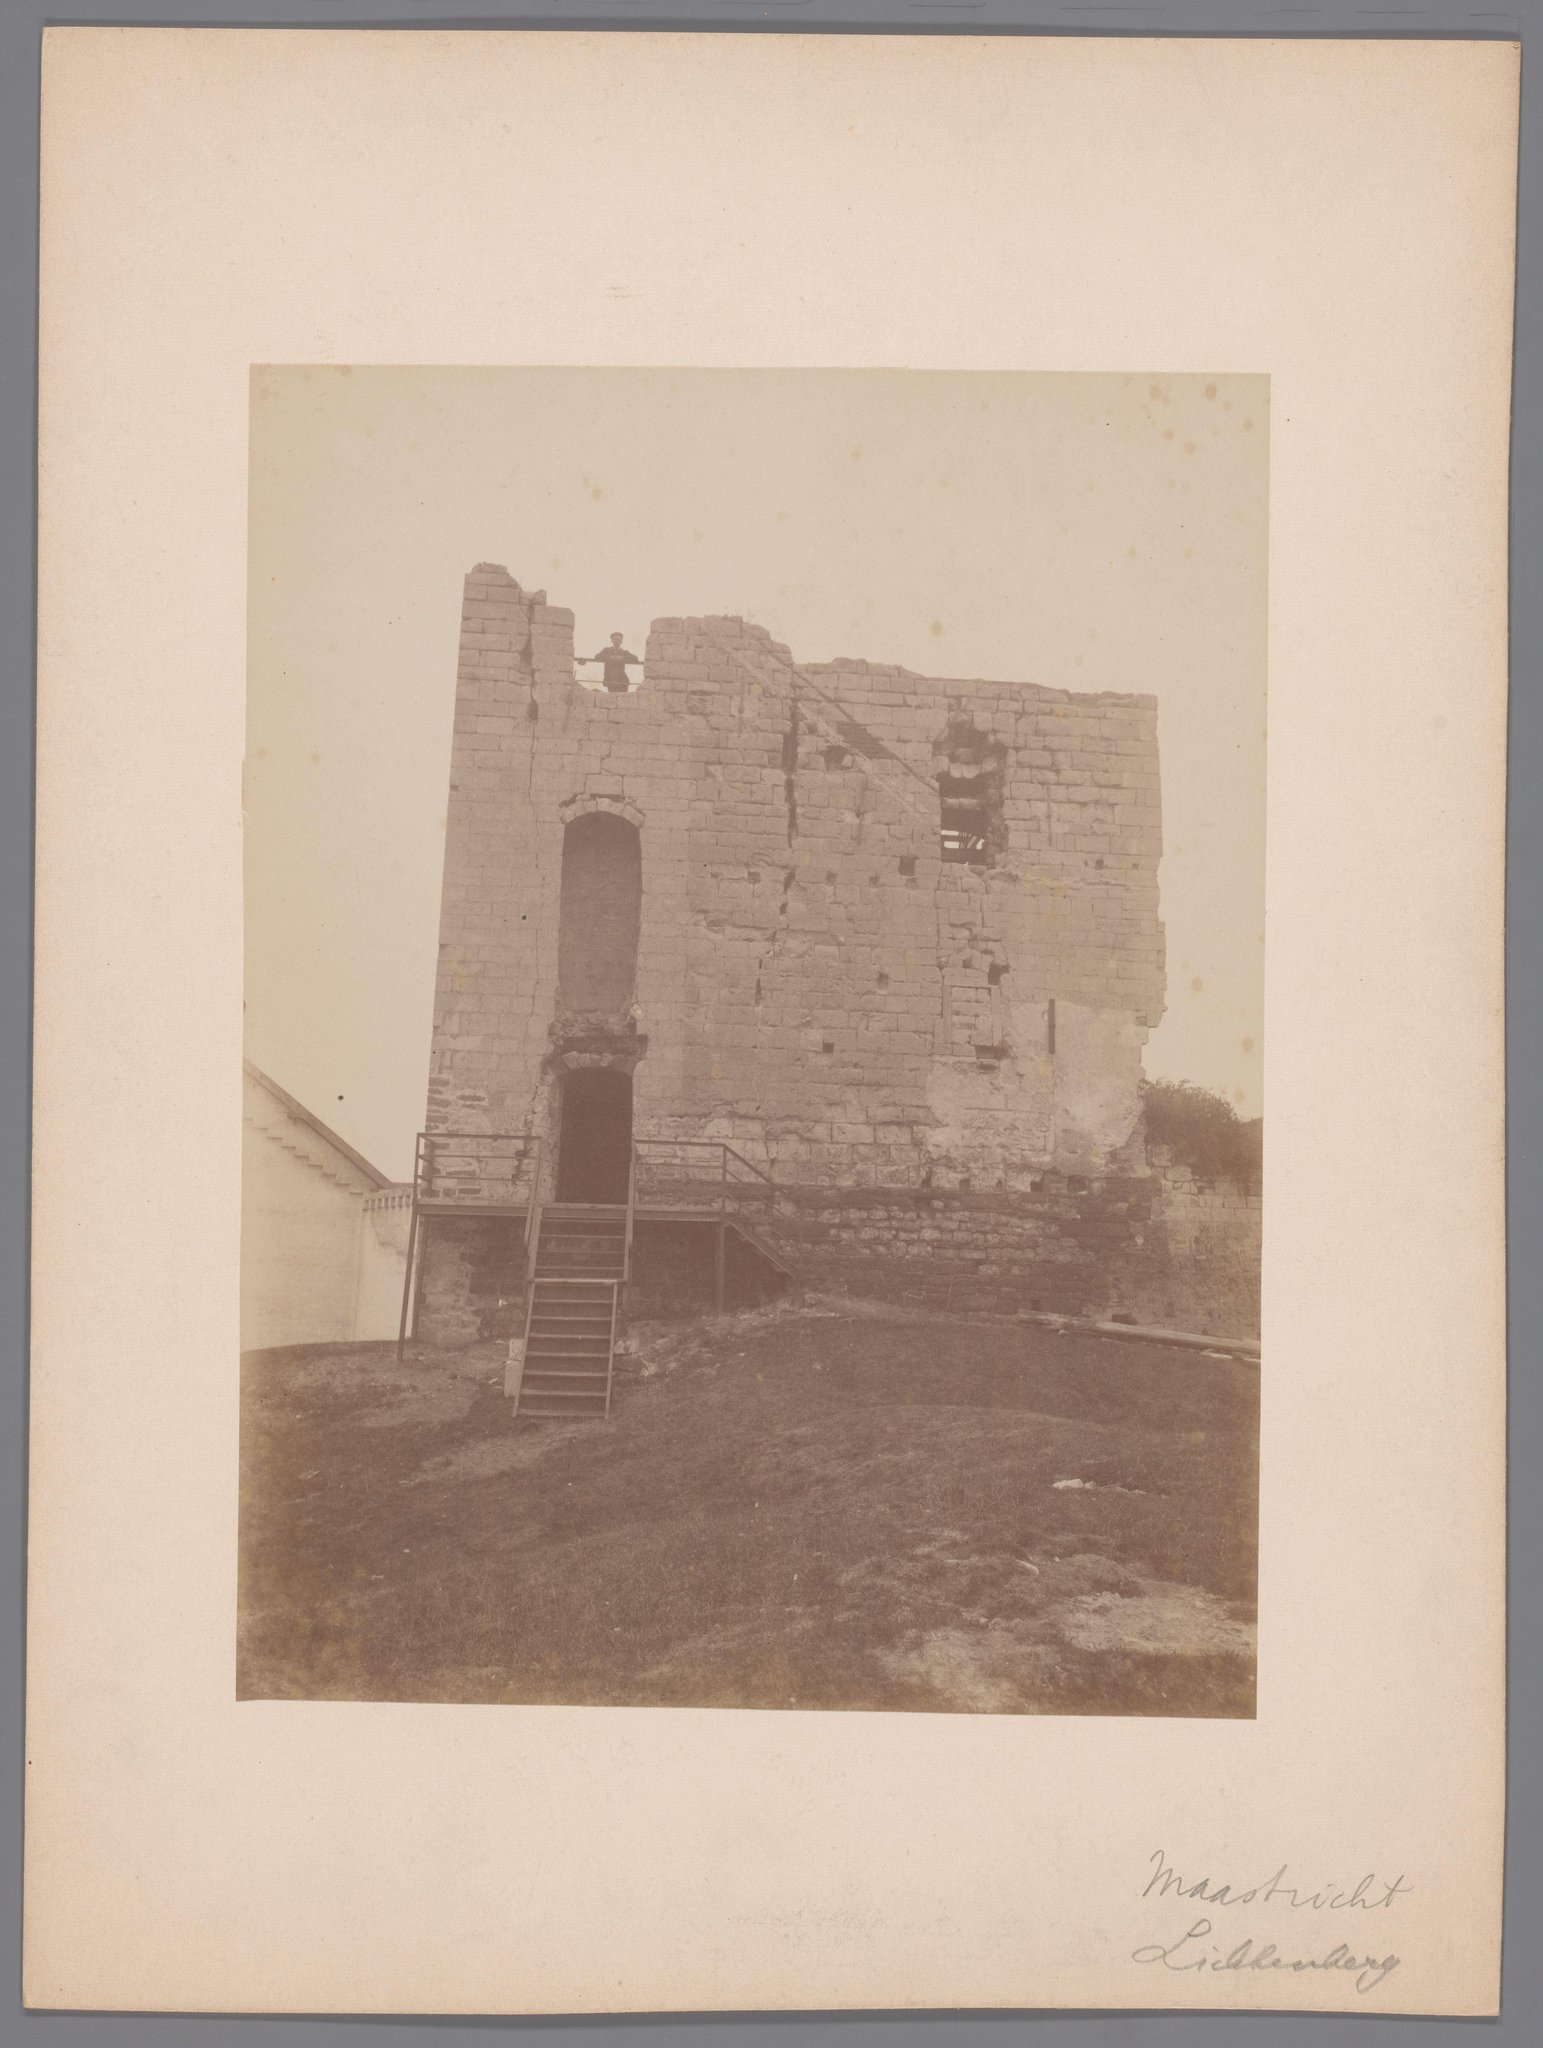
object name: photograph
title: Kasteelruïne Lichtenberg te Maastricht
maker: anoniem (monumentenzorg)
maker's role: fotograaf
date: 1904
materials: cardboard, photographic support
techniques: albumen print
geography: maastricht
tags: ruin of a dwelling, house, castle, etc.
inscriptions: annotation: ‘Maastricht/ Lichtenberg’, annotation: ‘Pietersberg/ Ruine Lichtenberg of Havante bij Maastricht (L.)/ Havante/ Oct 1904’